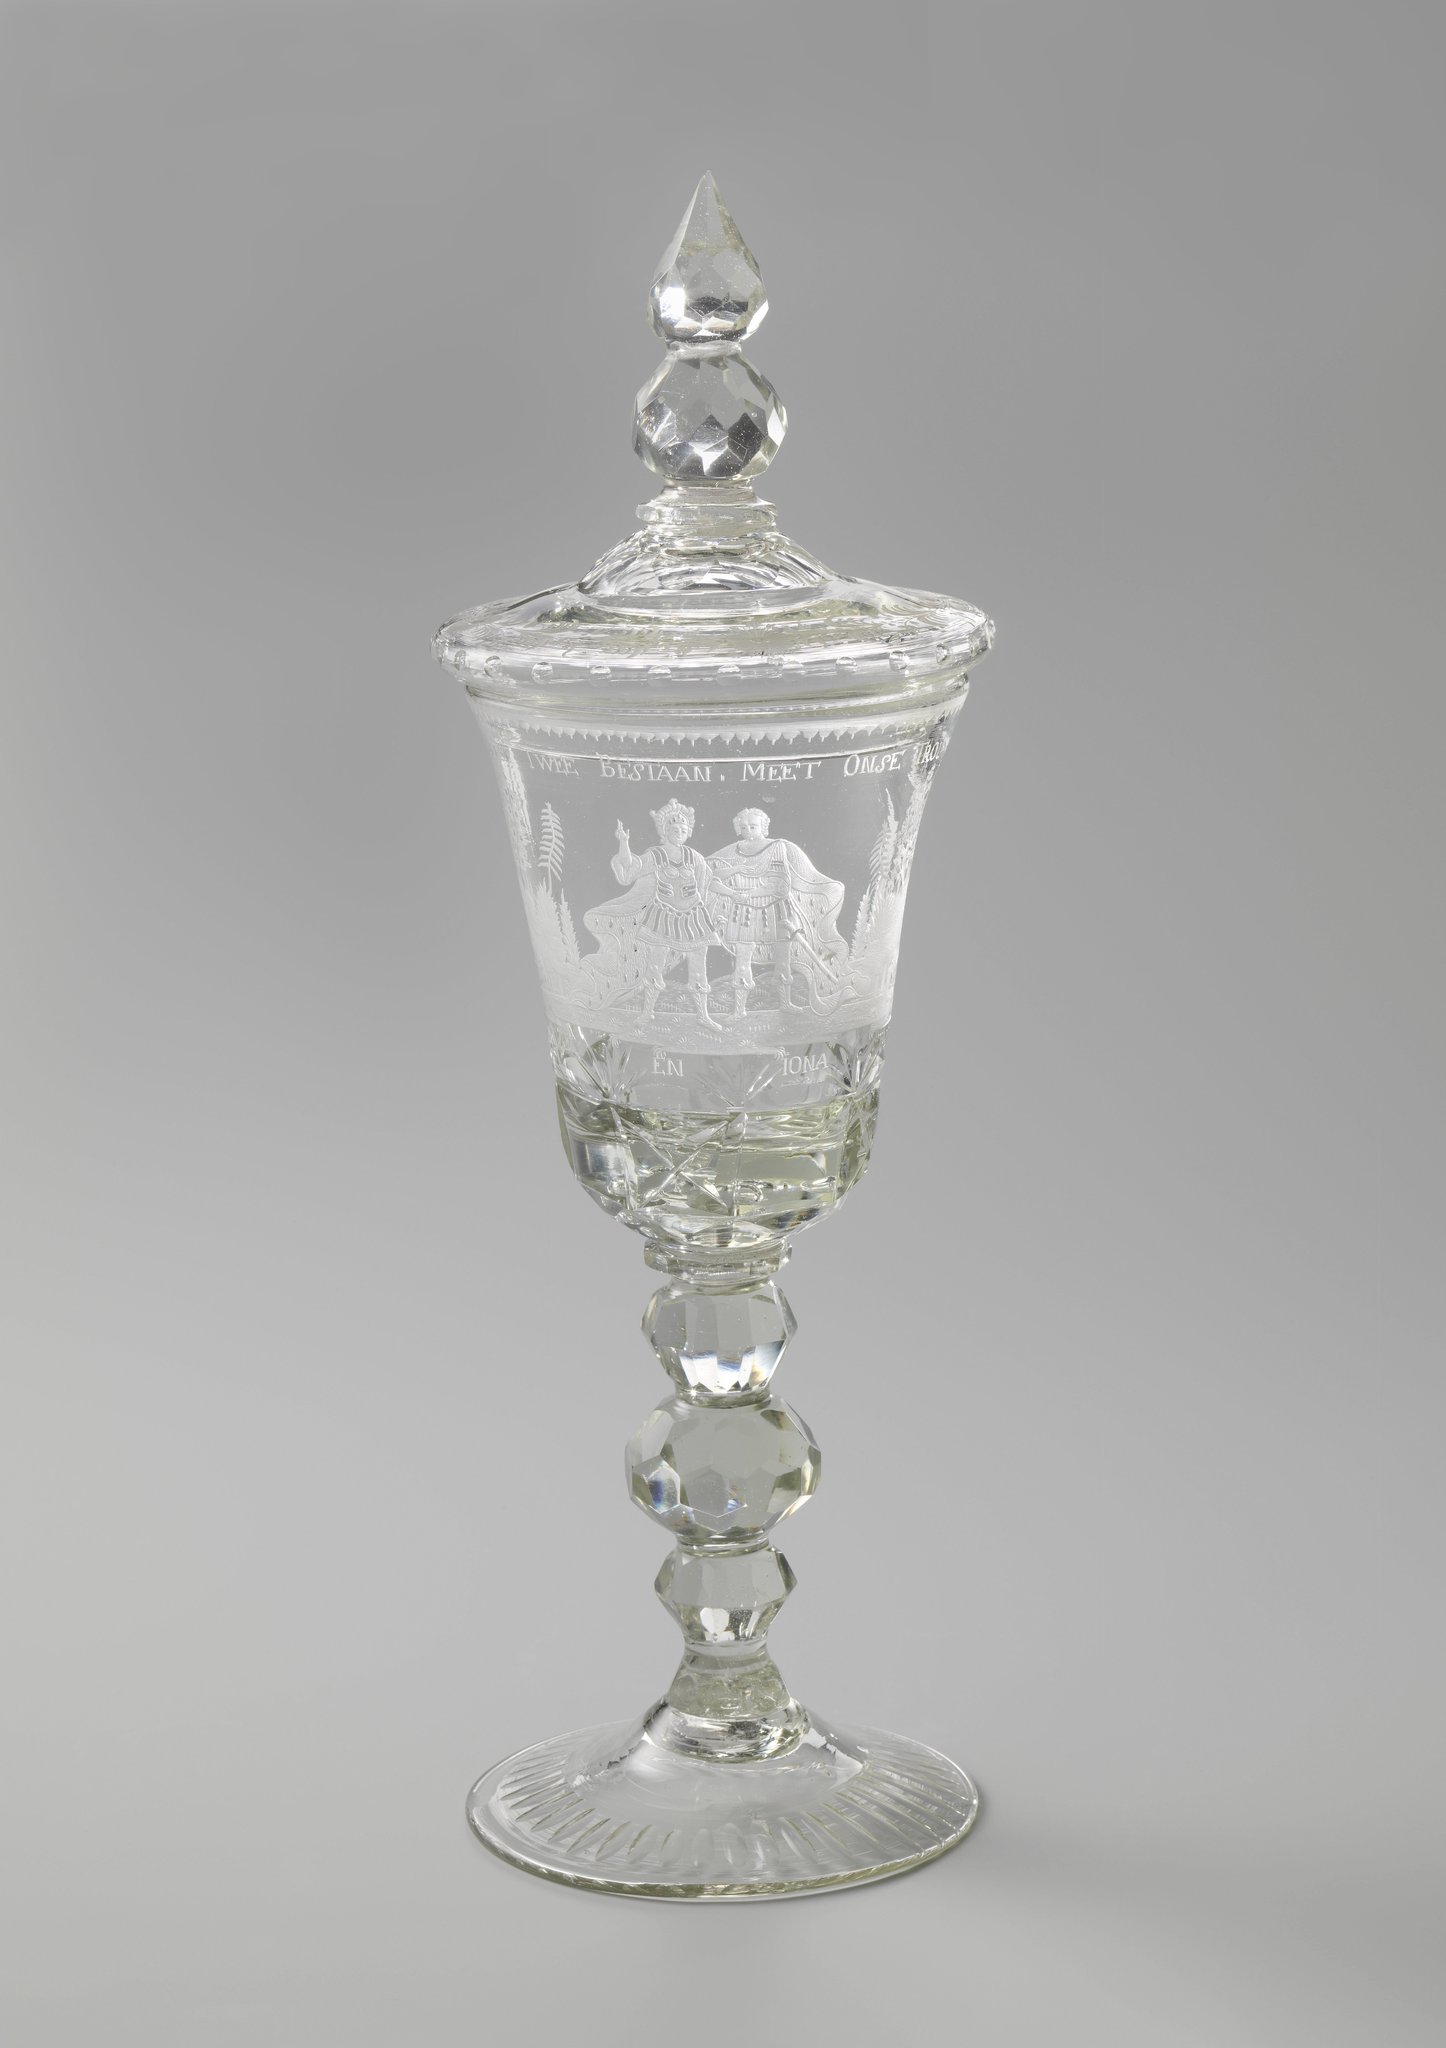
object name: goblet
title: Lidded goblet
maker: Anonymous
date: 1725-1750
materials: glass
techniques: glassblowing, grinding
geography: northern netherlands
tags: david consulting jonathan (in the field); jonathan pledges his loyalty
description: The goblet is engraved with the biblical figures of King David and Jonathan. The inscription, ‘Gleyck deese twee bestaan moet onse trouwe gaan’ (Our loyalty should be like that of these two), alludes to their faithful friendship.